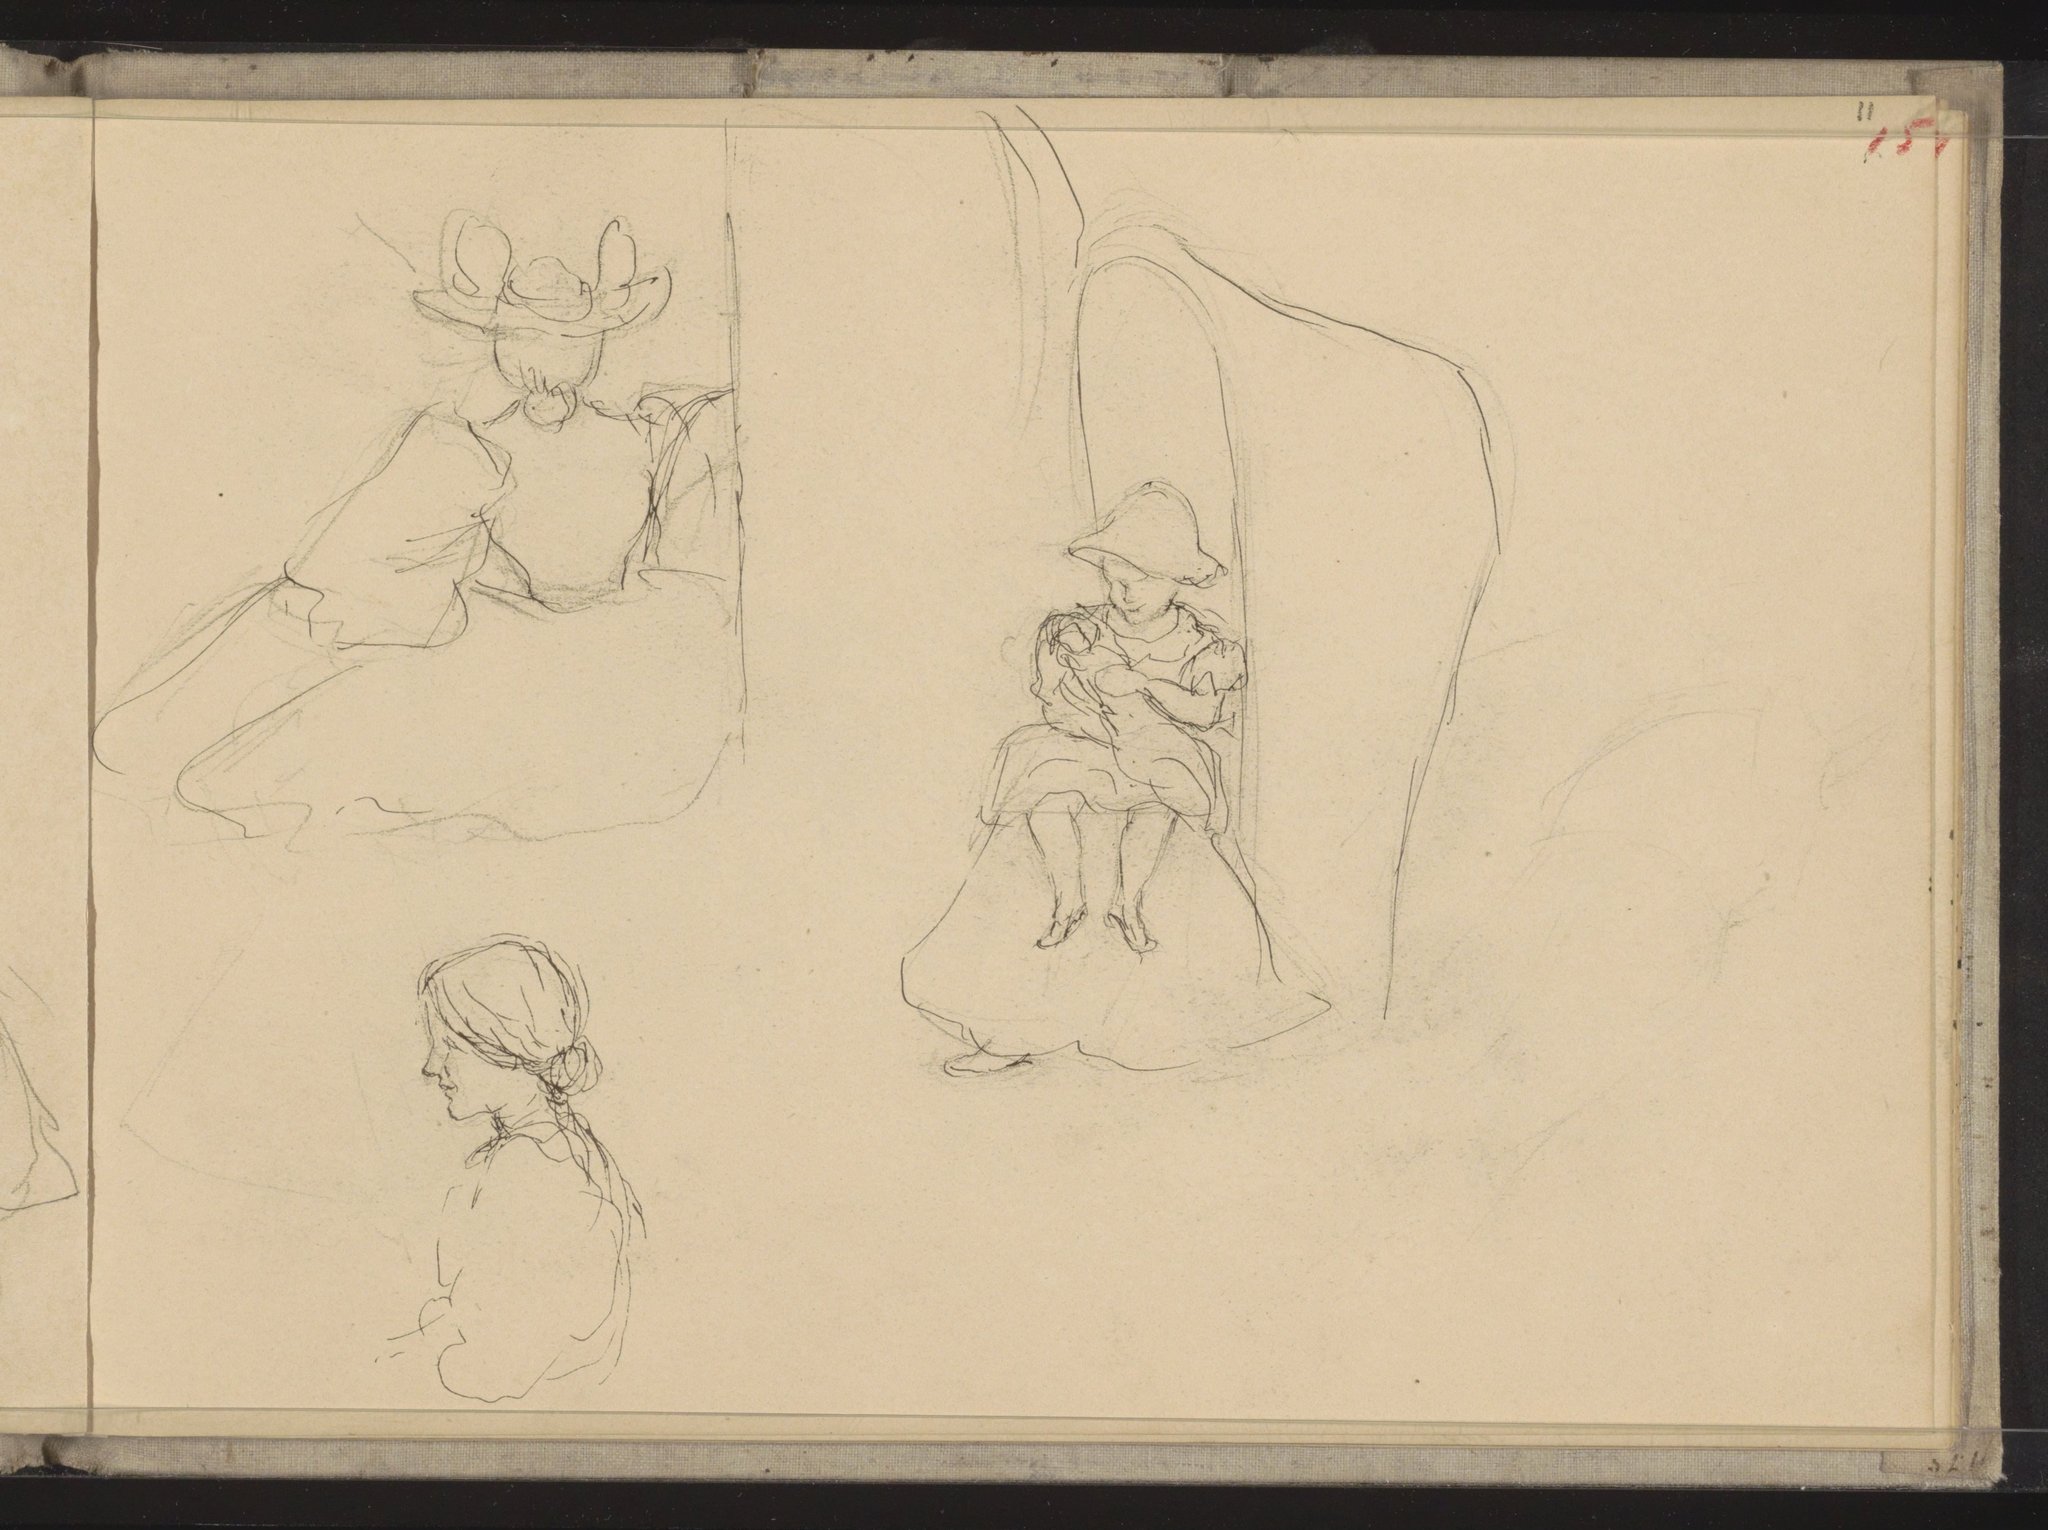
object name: sketchbook leaf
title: Studieblad, onder andere met een zittende vrouw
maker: jozef israëls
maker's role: draughtsman, painter, print maker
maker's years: 1824-1911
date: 1834-1911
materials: ink, paper, pencil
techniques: pen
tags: sitting figure, girl (child between toddler and youth)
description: Tevens een studie van een vrouw en van een meisje dat met een pop op schoot bij een vrouw op een stoel zit. Blad 11 recto uit een schetsboek met 18 bladen.